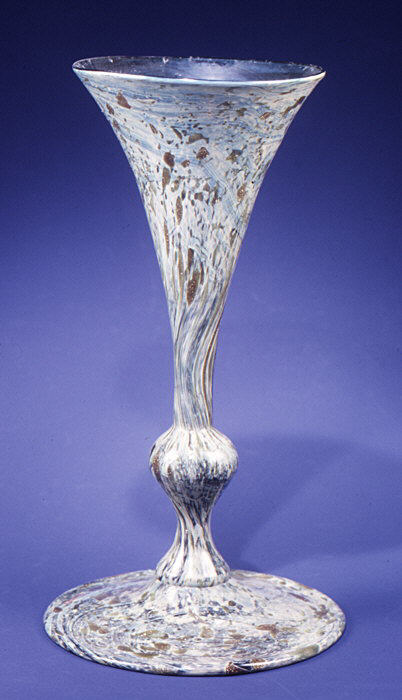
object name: vase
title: Blue and golden-toned aventurine glass vase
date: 1801-1900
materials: glass